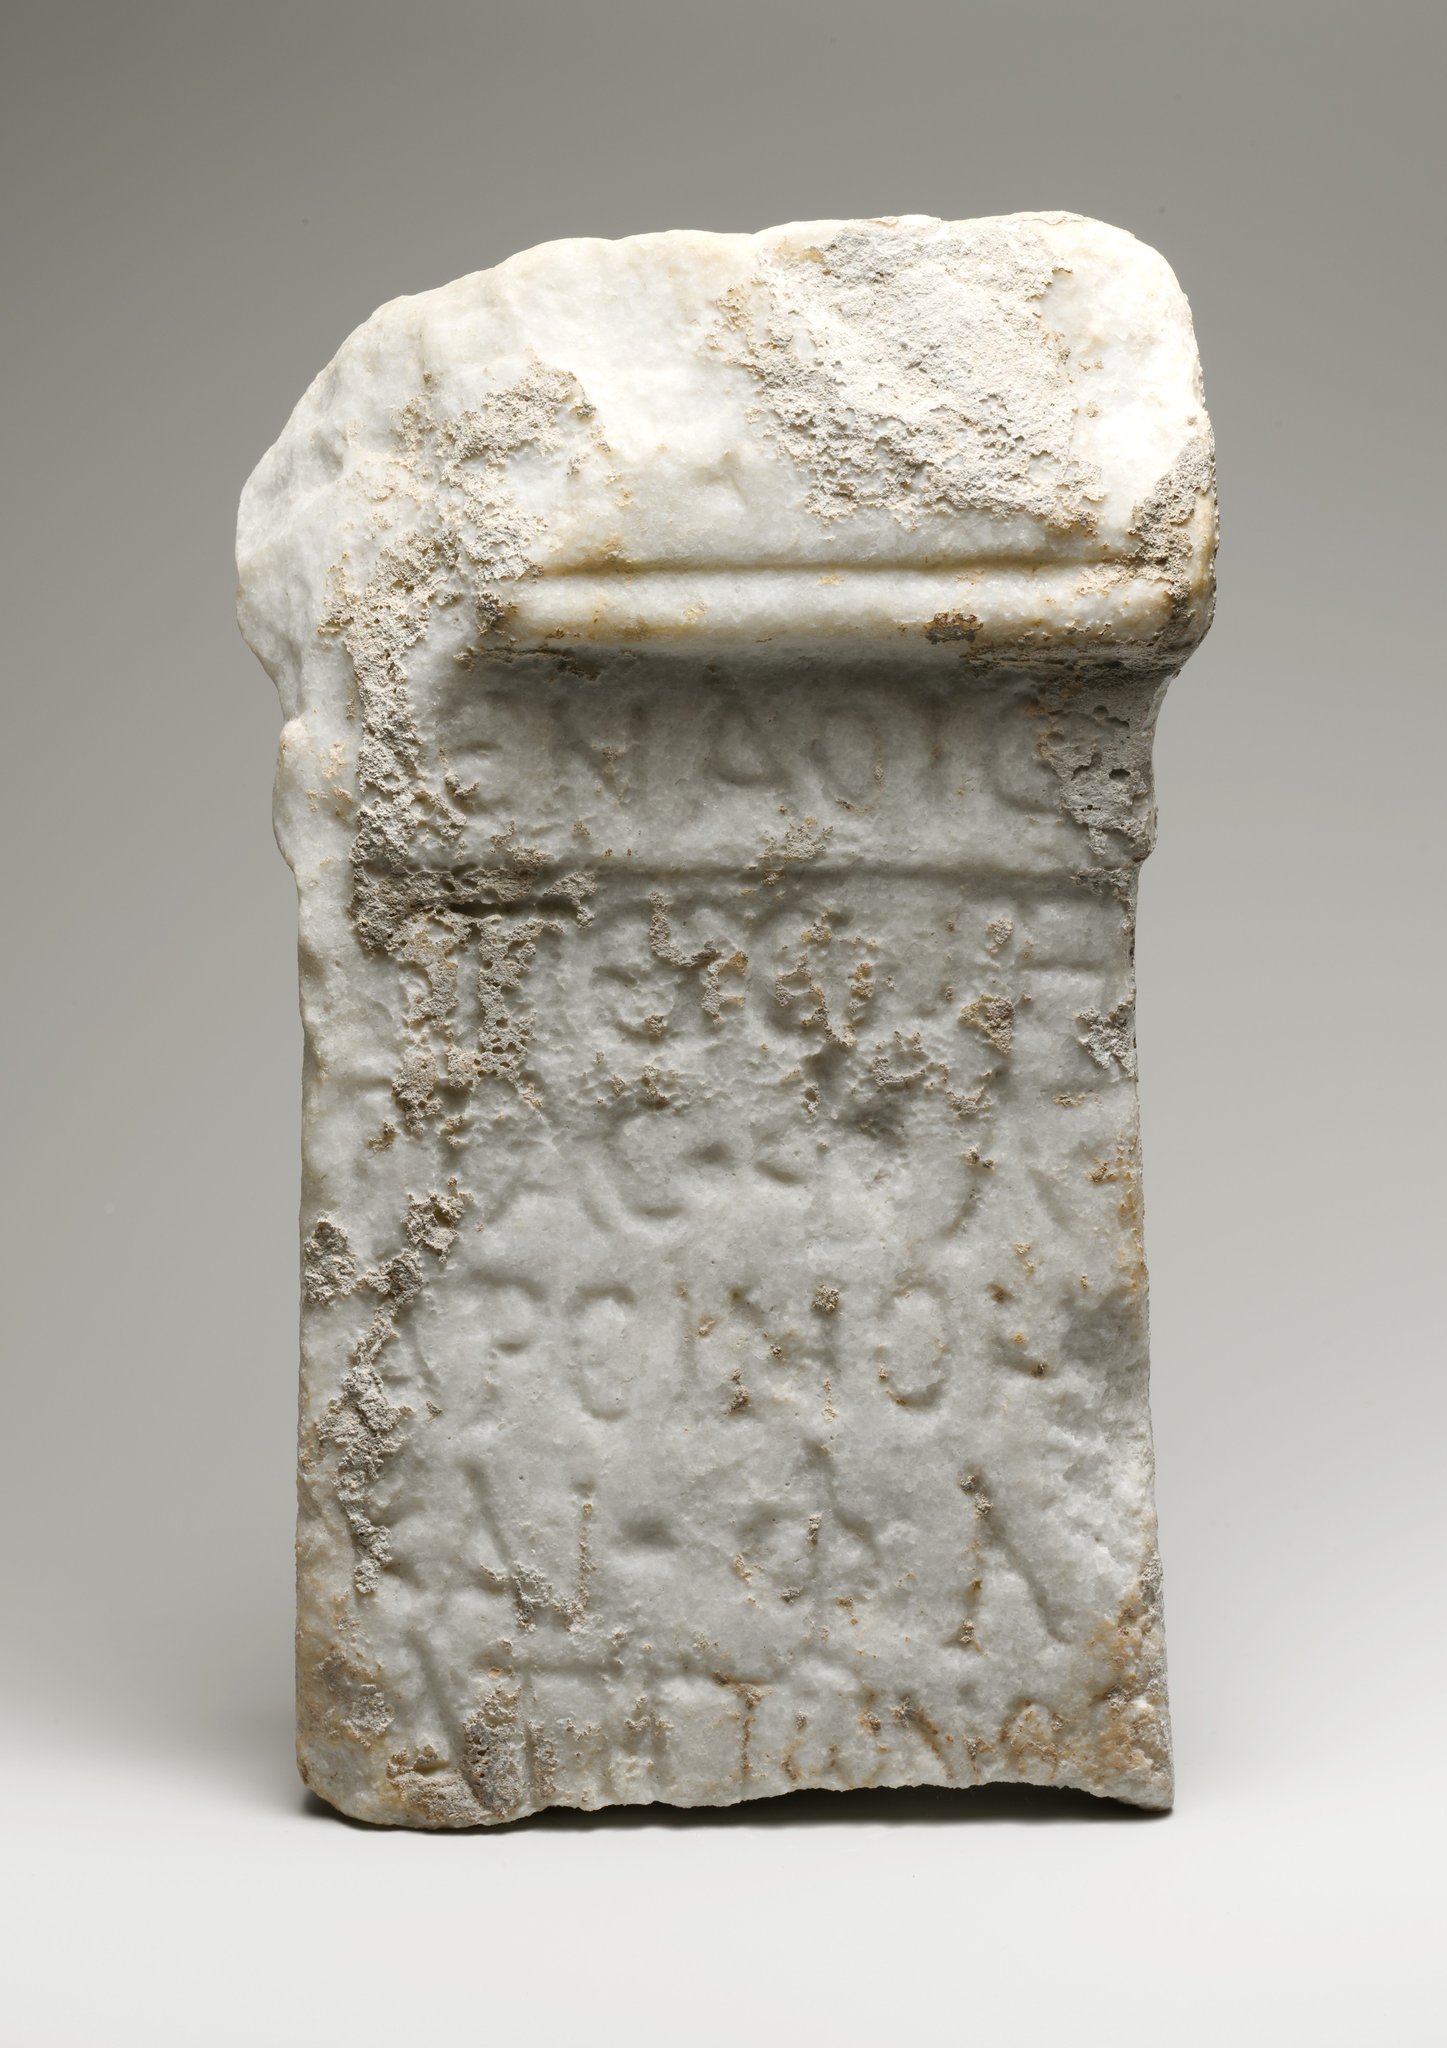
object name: votive relief fragment, inscription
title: Fragmentary marble votive altar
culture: roman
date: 267-333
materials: marble